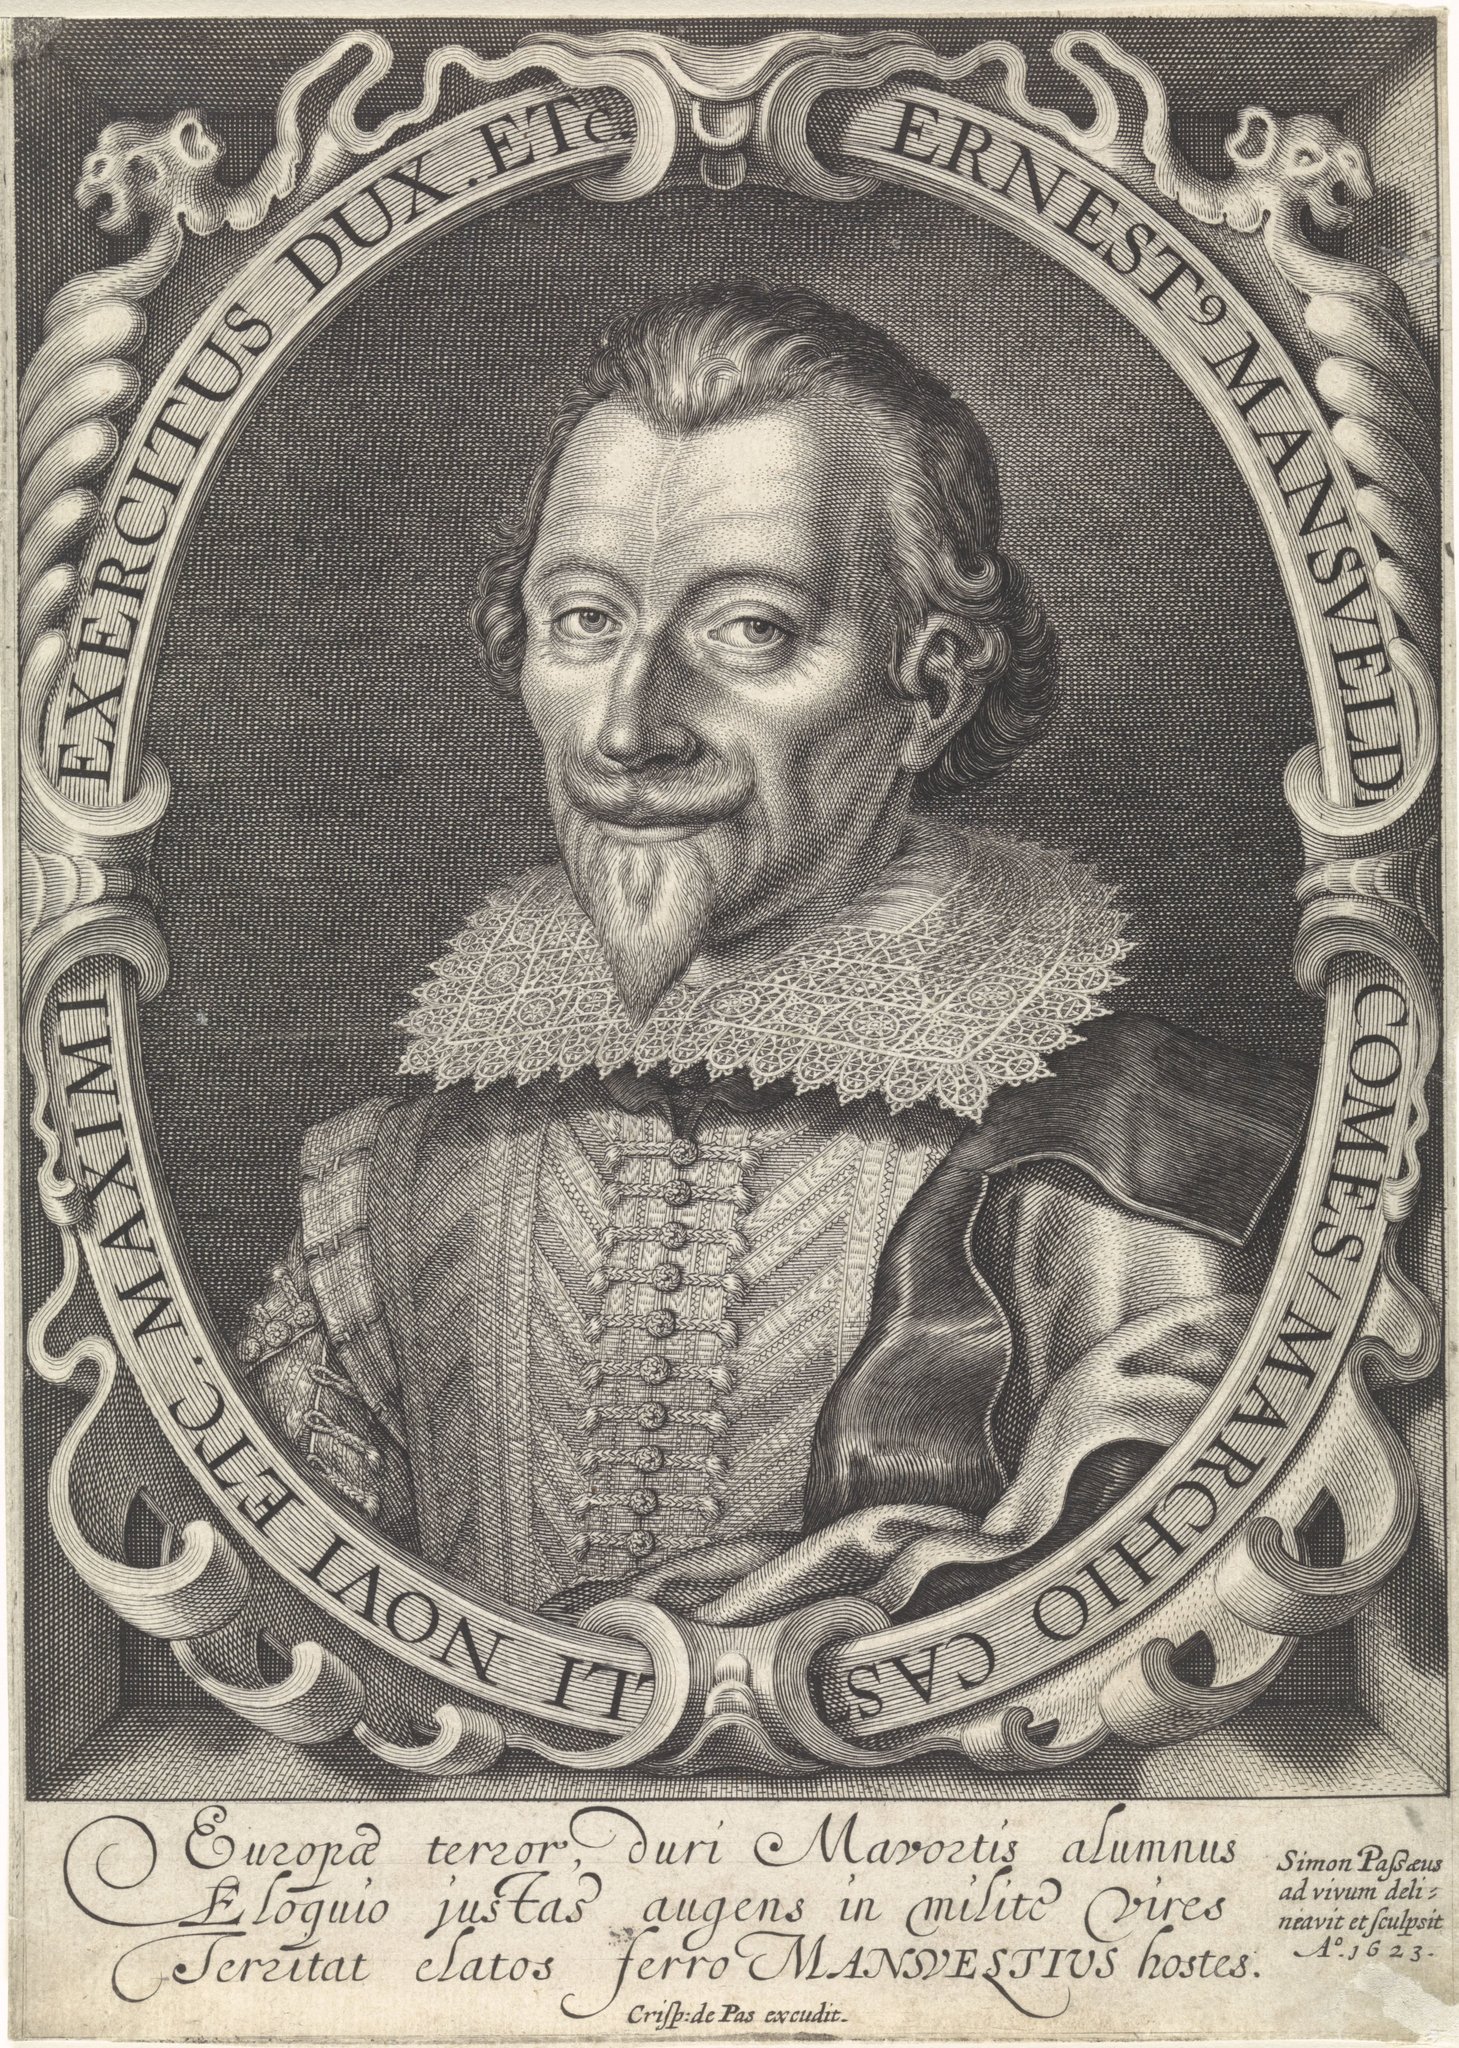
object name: print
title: Portret van Peter Ernst (II), graaf van Mansfeld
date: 1623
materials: paper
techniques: engraving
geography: paris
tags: peter ernst von mansfeld (graaf)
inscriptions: date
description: Portret van de legeraanvoerder Peter Ernst (II), graaf van Mansfeld. In het randschrift van de omlijsting de naam en functie van de geportretteerde in het Latijn. In de marge een drieregelig onderschrift in het Latijn.